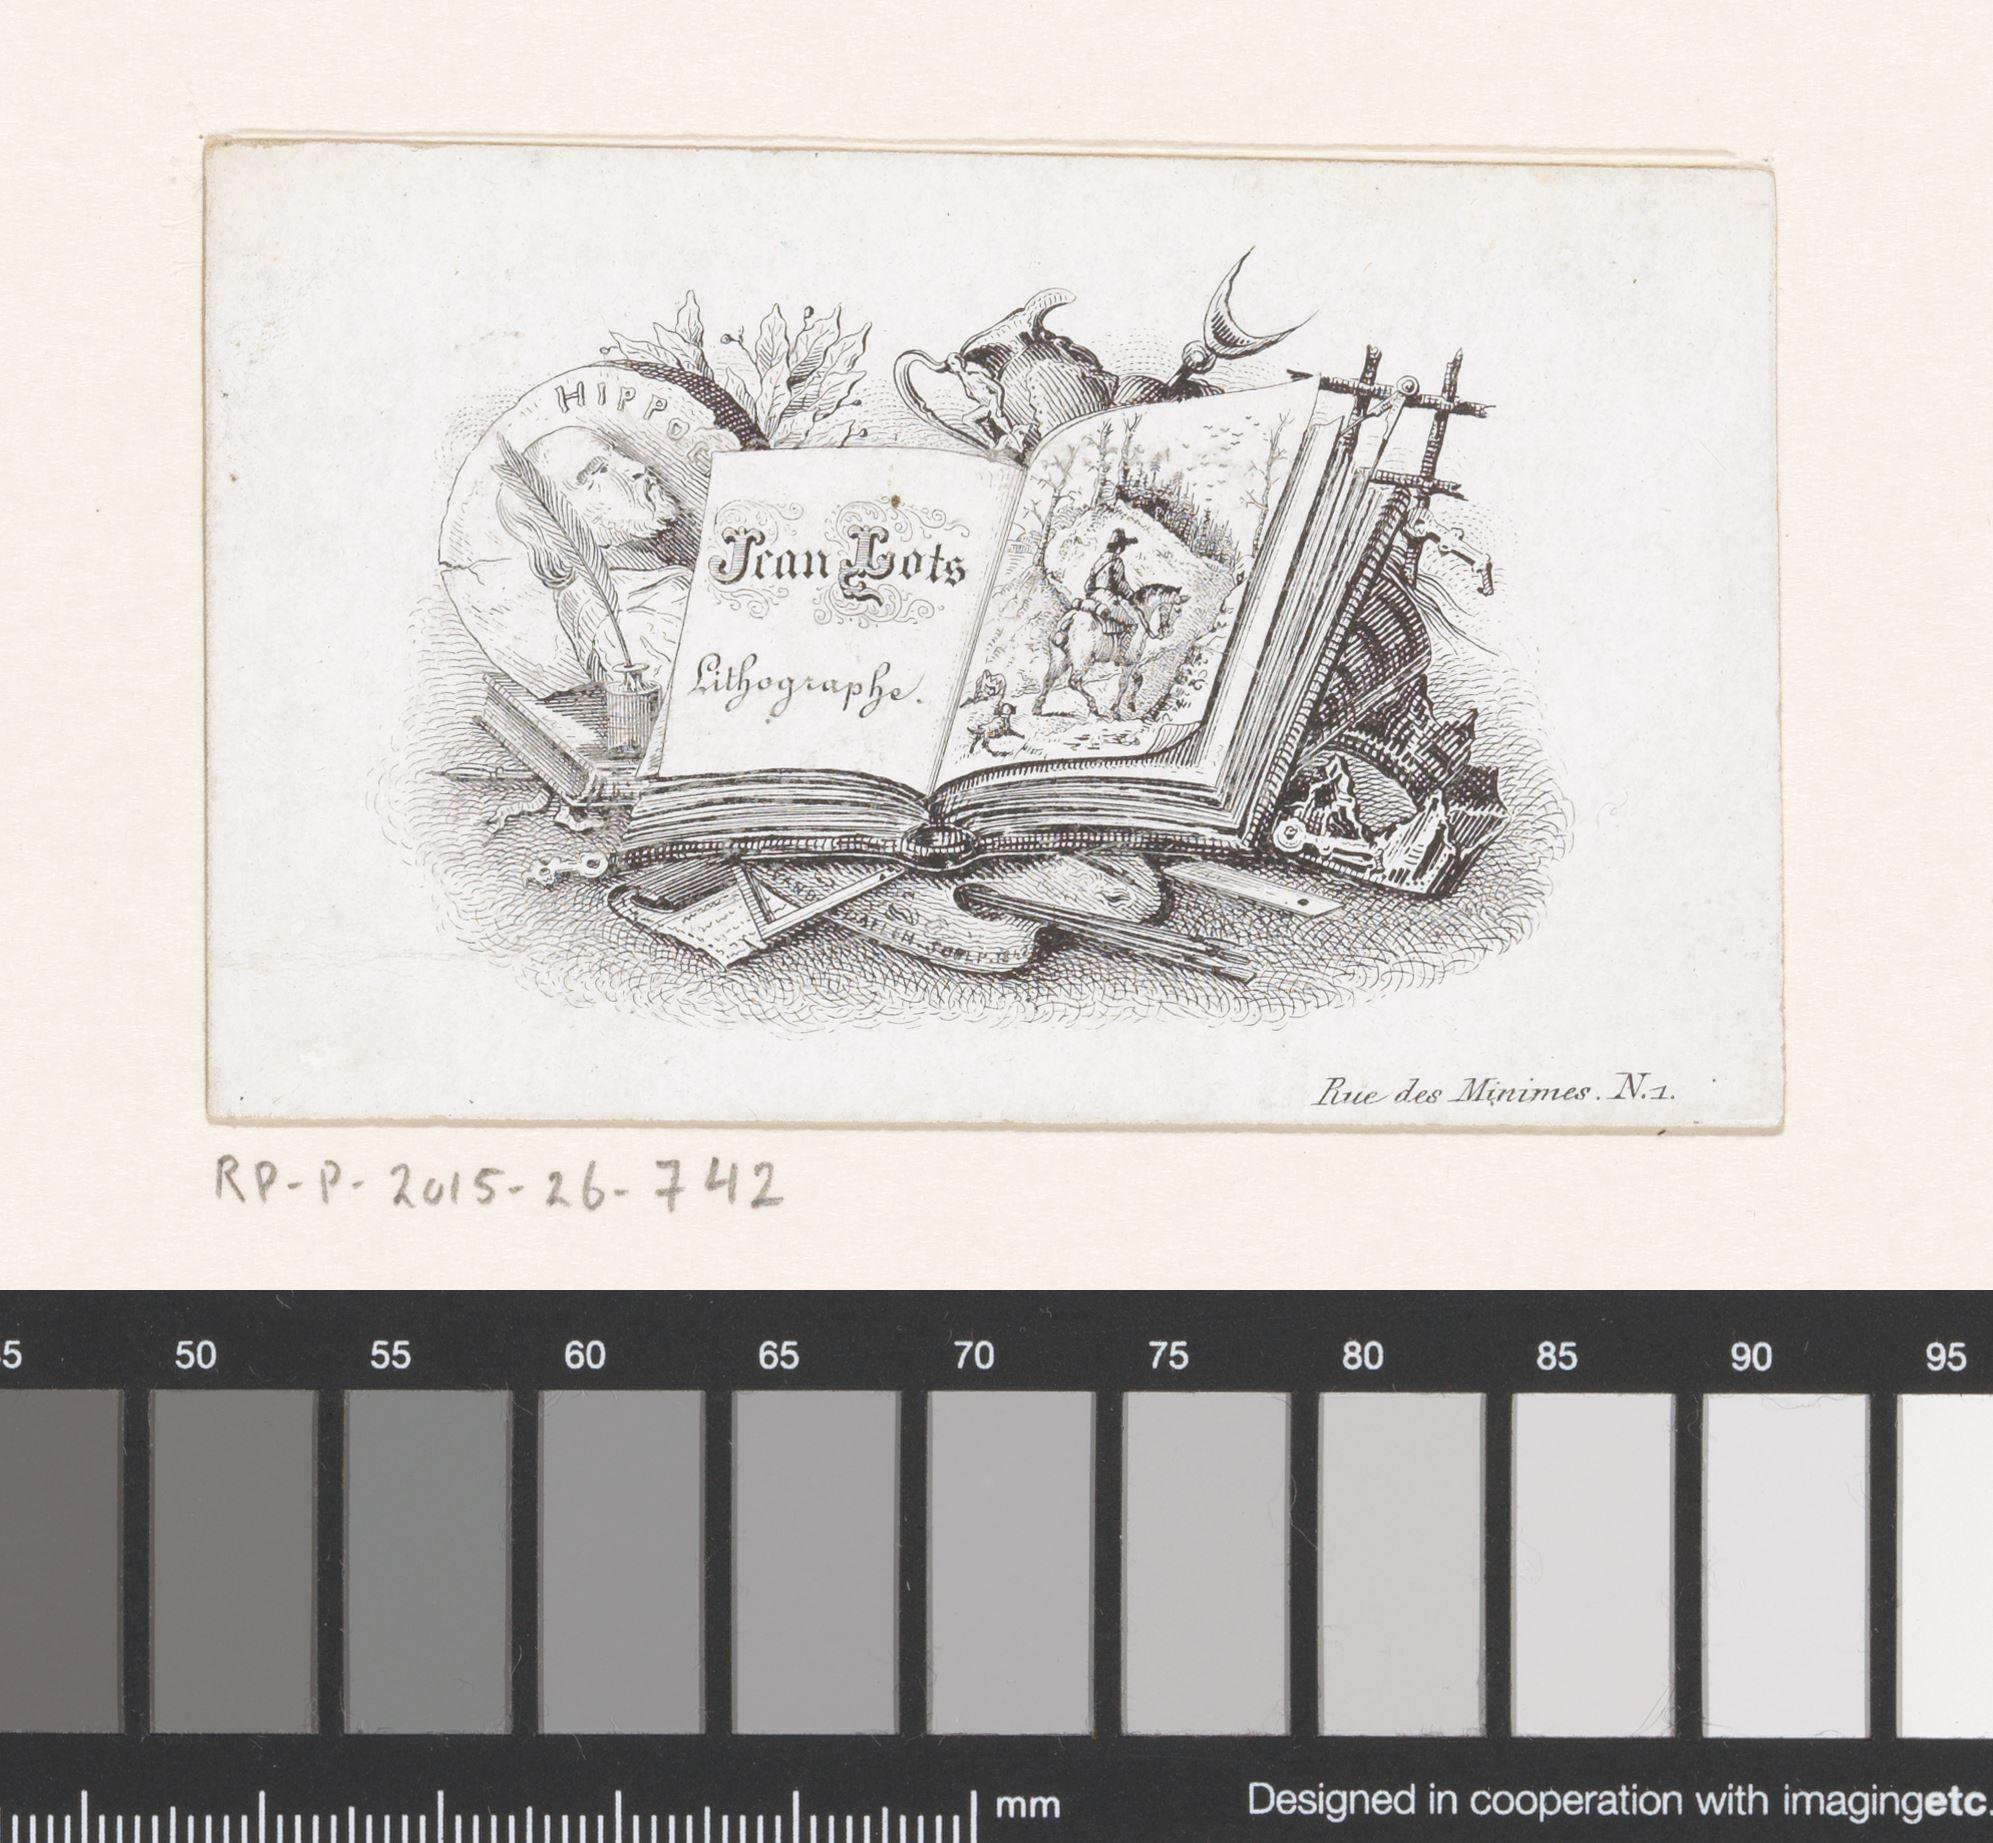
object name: visiting card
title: Visitekaartje van drukker Jean Lots te Brussel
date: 1842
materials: porcelainized cardboard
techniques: lithograph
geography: brussels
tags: tools, implements of painter, book in which illustrations are essential - mm - book open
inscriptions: collector's mark: Lugt 2228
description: In het midden een opengeslagen boek met op de rechterpagina een afbeelding van een ruiter op een bospad. Daaromheen onder anderen een schilderspalet en een medaillon met het portret van Hippocrates.